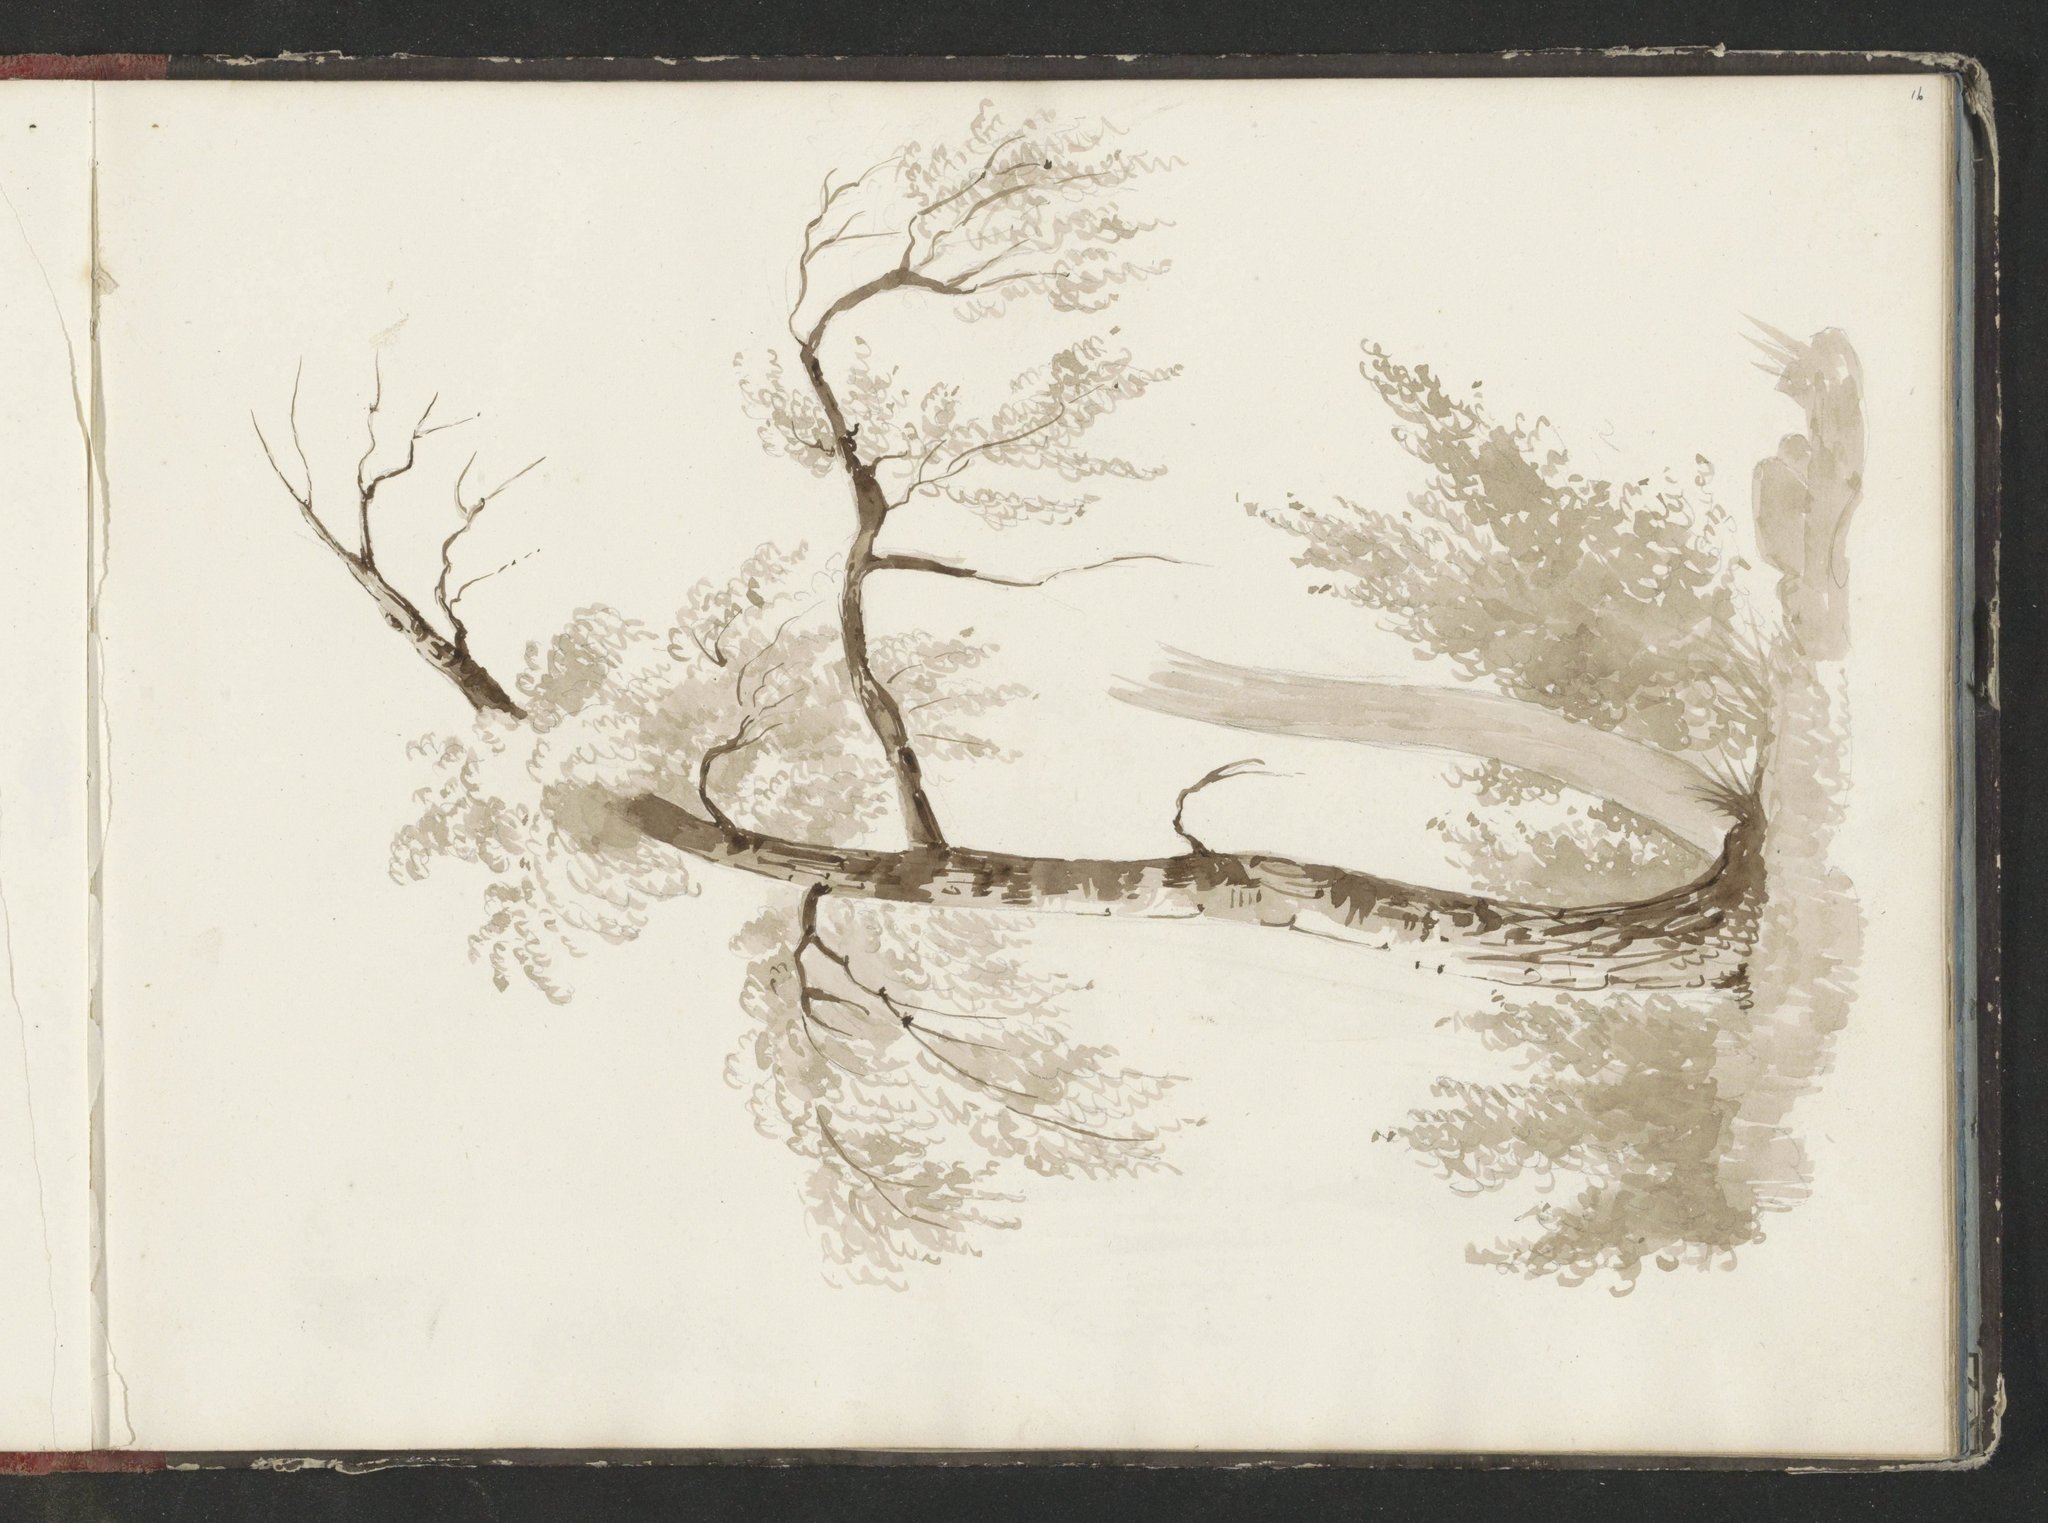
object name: sketchbook leaf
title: Landschap met een boom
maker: Anonymous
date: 1819-1870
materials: ink, paper, pencil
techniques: brush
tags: trees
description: Blad 16 recto uit een schetsboek met 39 bladen.